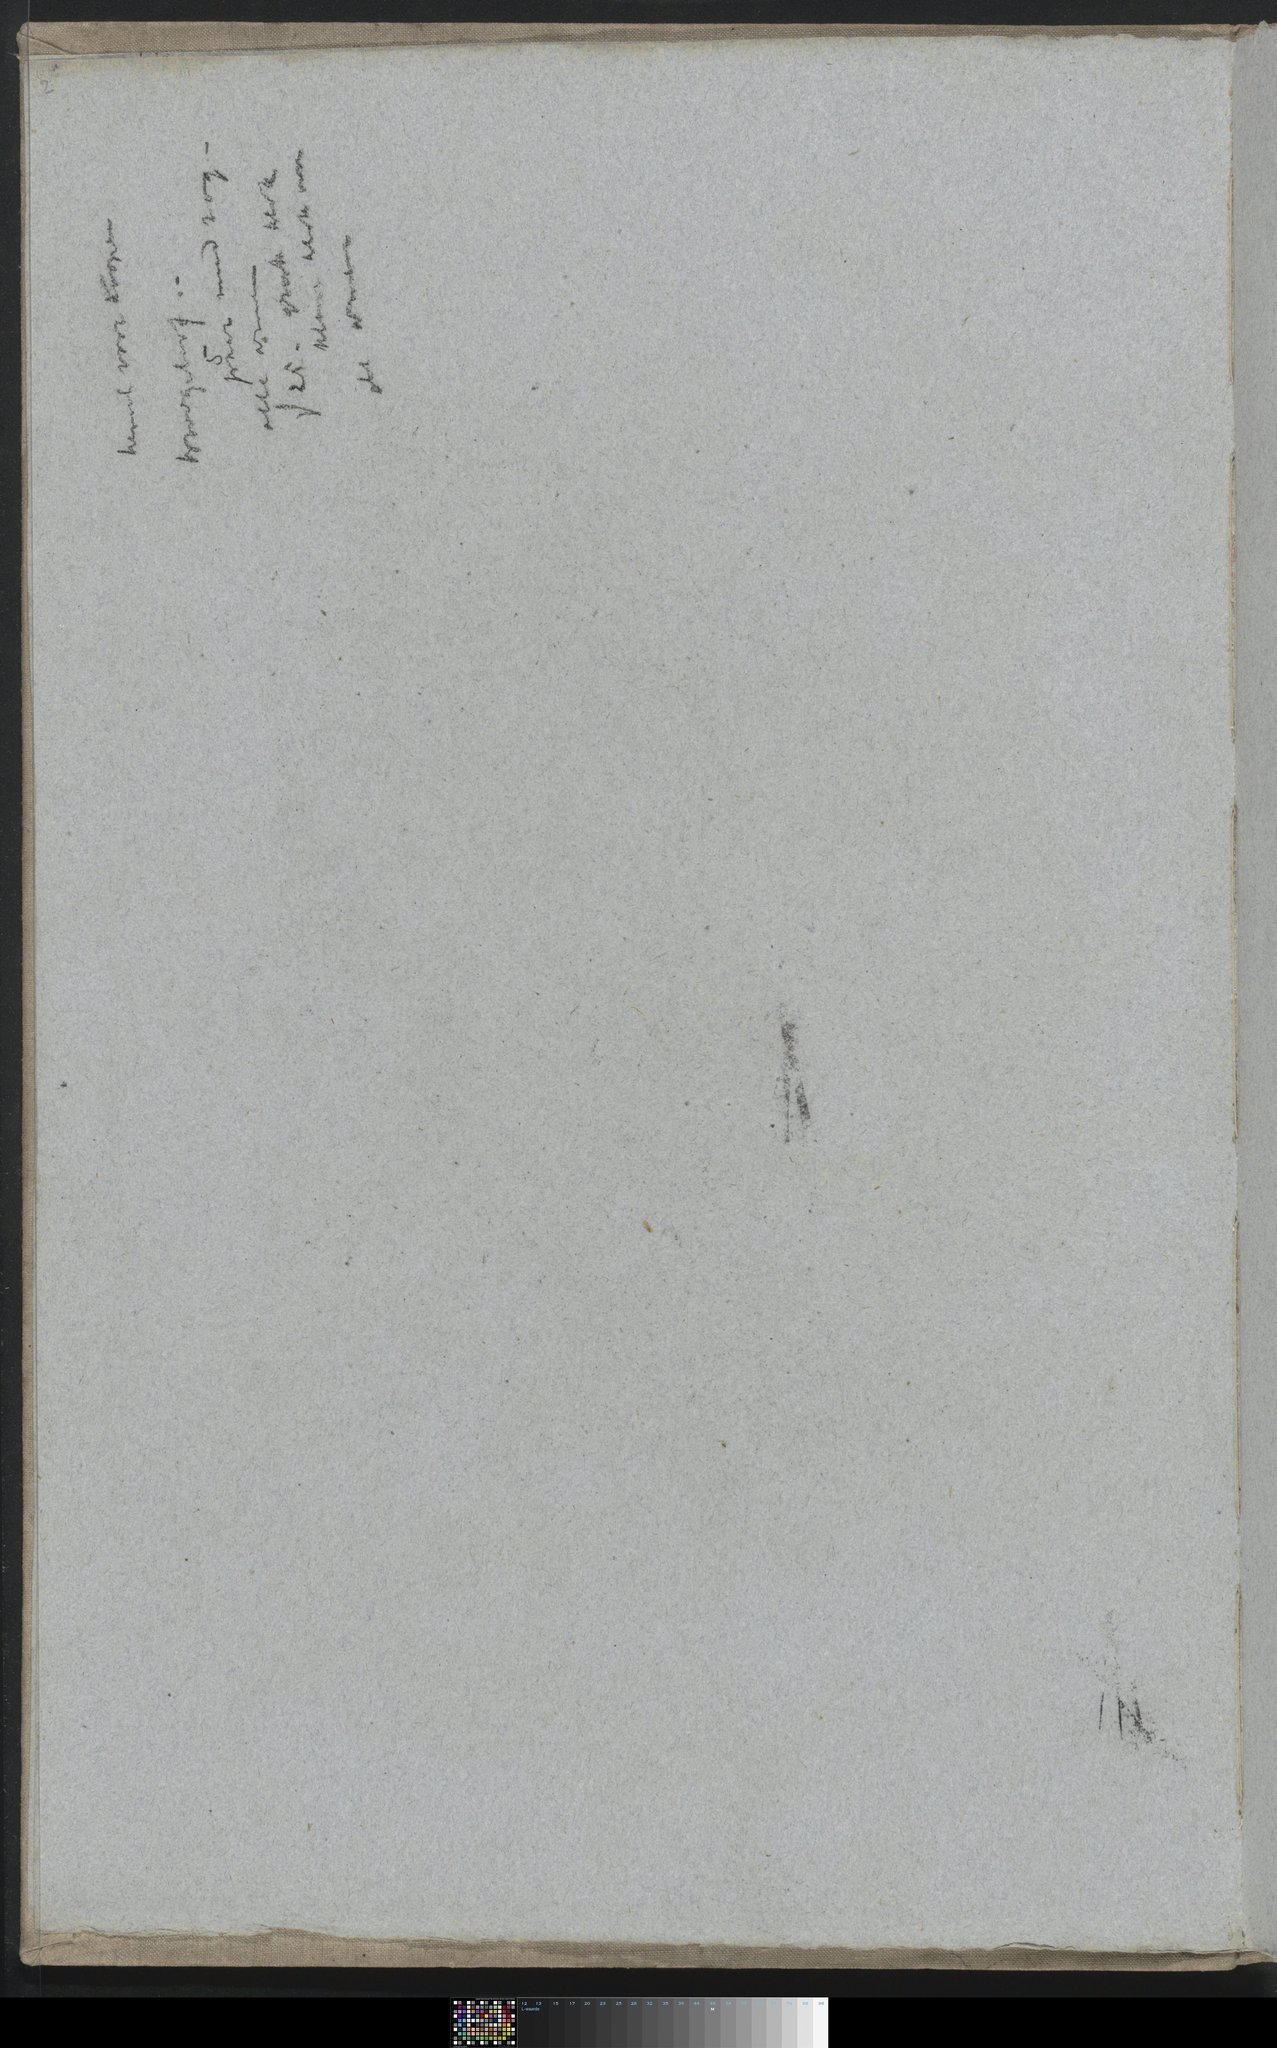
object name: sketchbook leaf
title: Annotaties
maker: willem witsen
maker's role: draughtsman, painter, print maker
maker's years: 1860-1923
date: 1886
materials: chalk, paper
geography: ewijkshoeve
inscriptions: annotation: ‘[...]’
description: Pagina 2 uit een schetsboek met 38 bladen betekend rond de Ewijkshoeve.